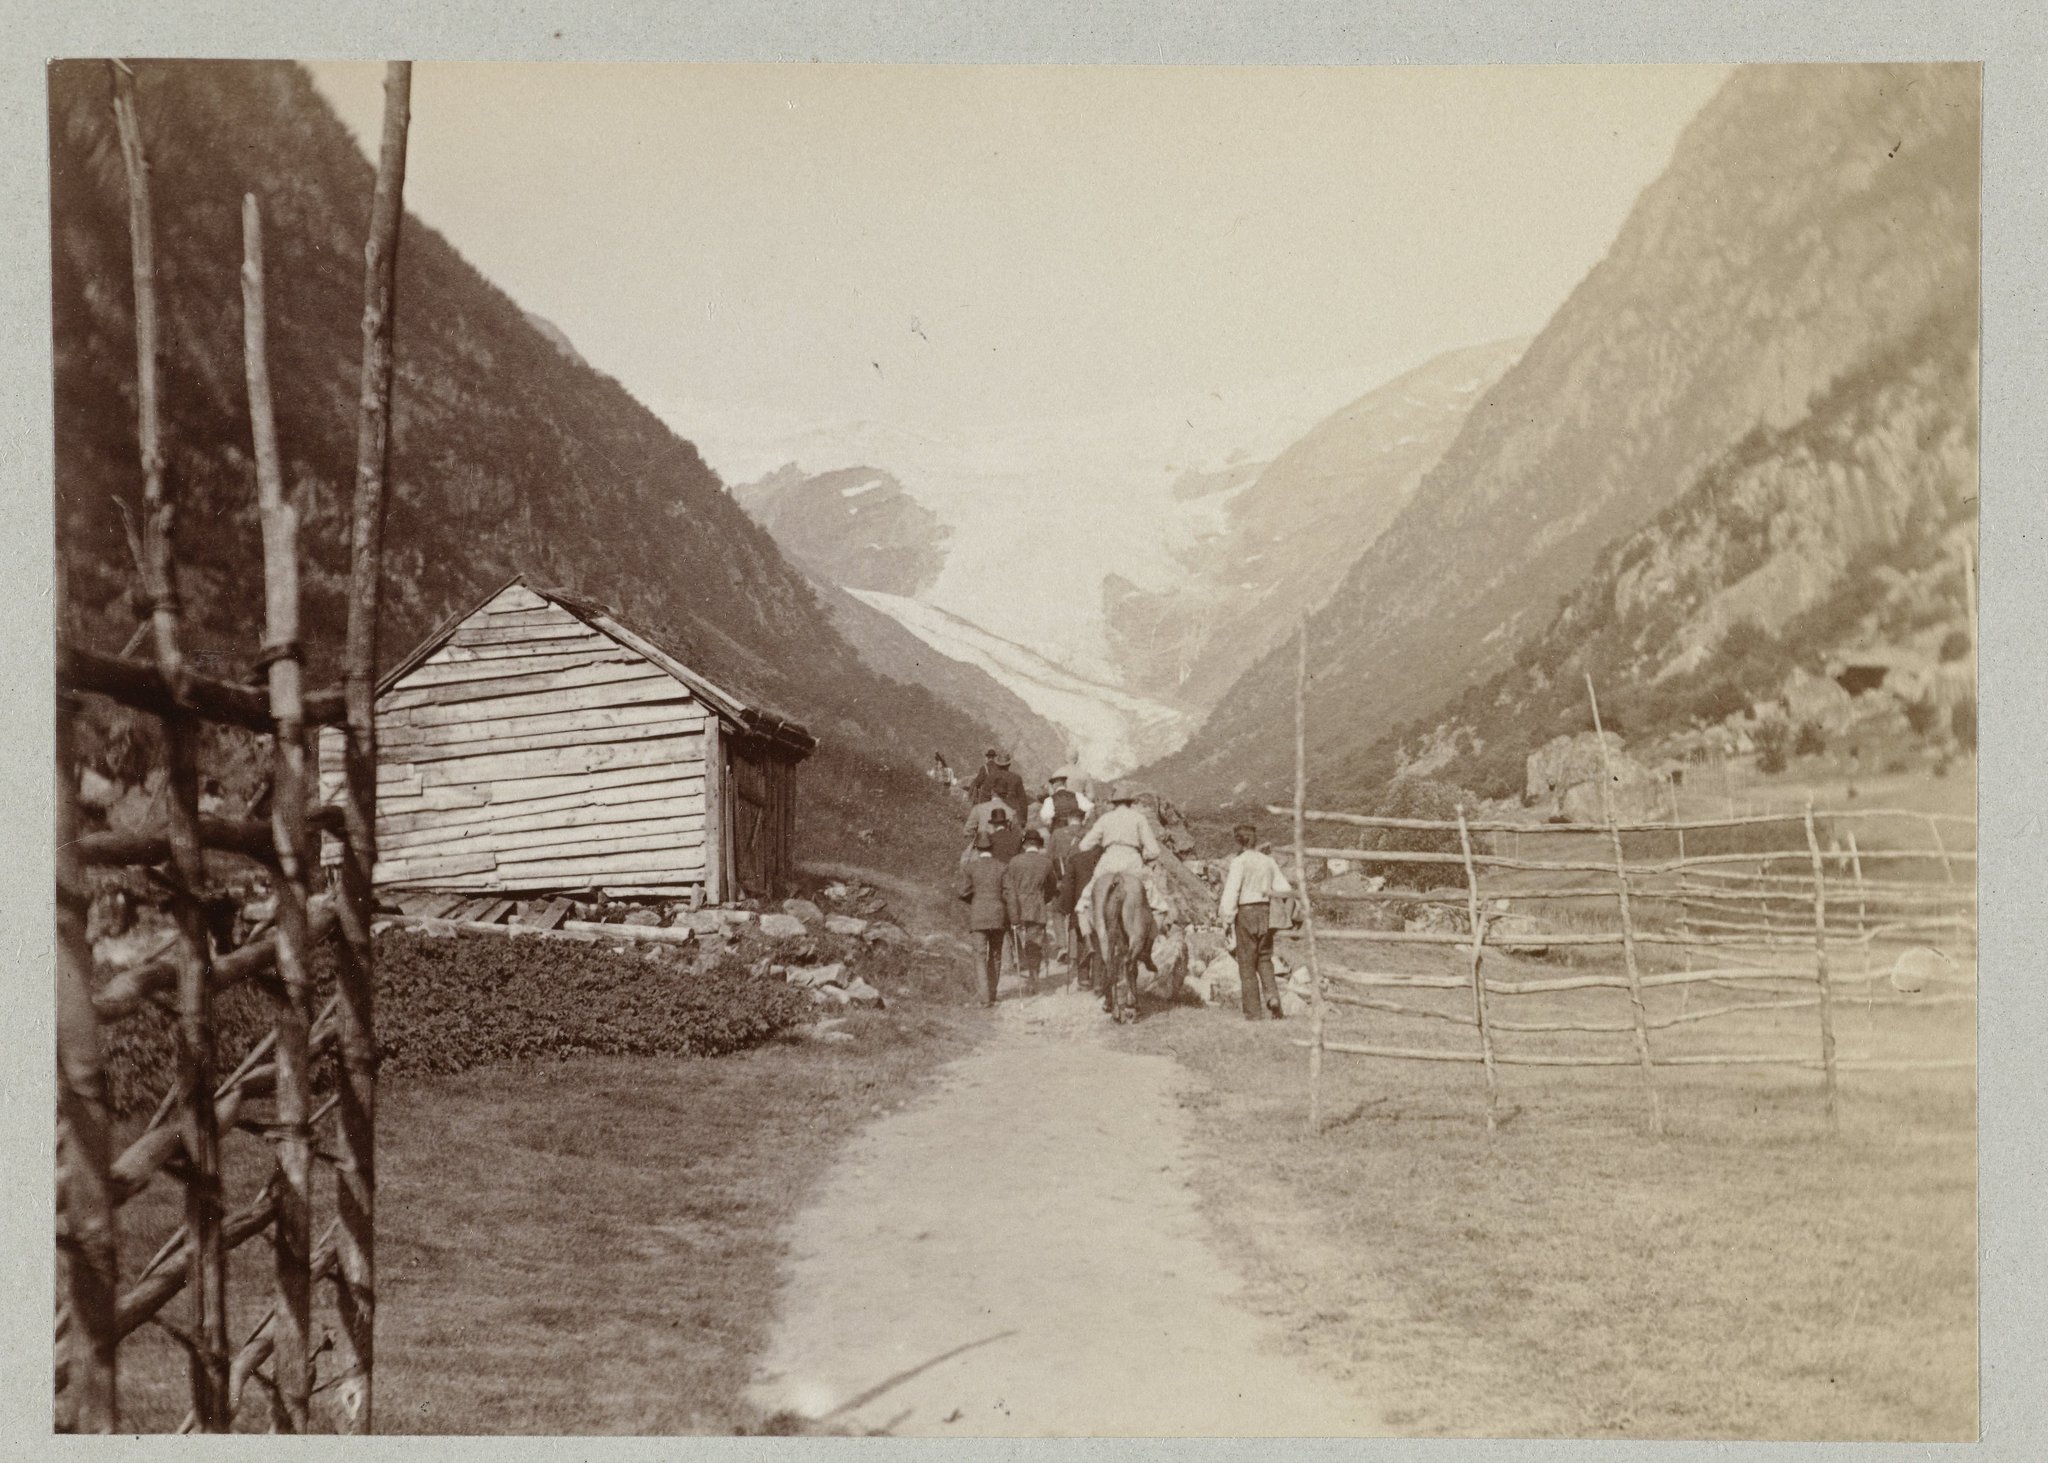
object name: photograph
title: Gezelschap met Keizer Wilhelm II tegen de achtergrond van de Buarbrae in Noorwegen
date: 1807-1889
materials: cardboard, paper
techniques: albumen print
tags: wilhelm ii (keizer van duitsland), norway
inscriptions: number: ‘6’